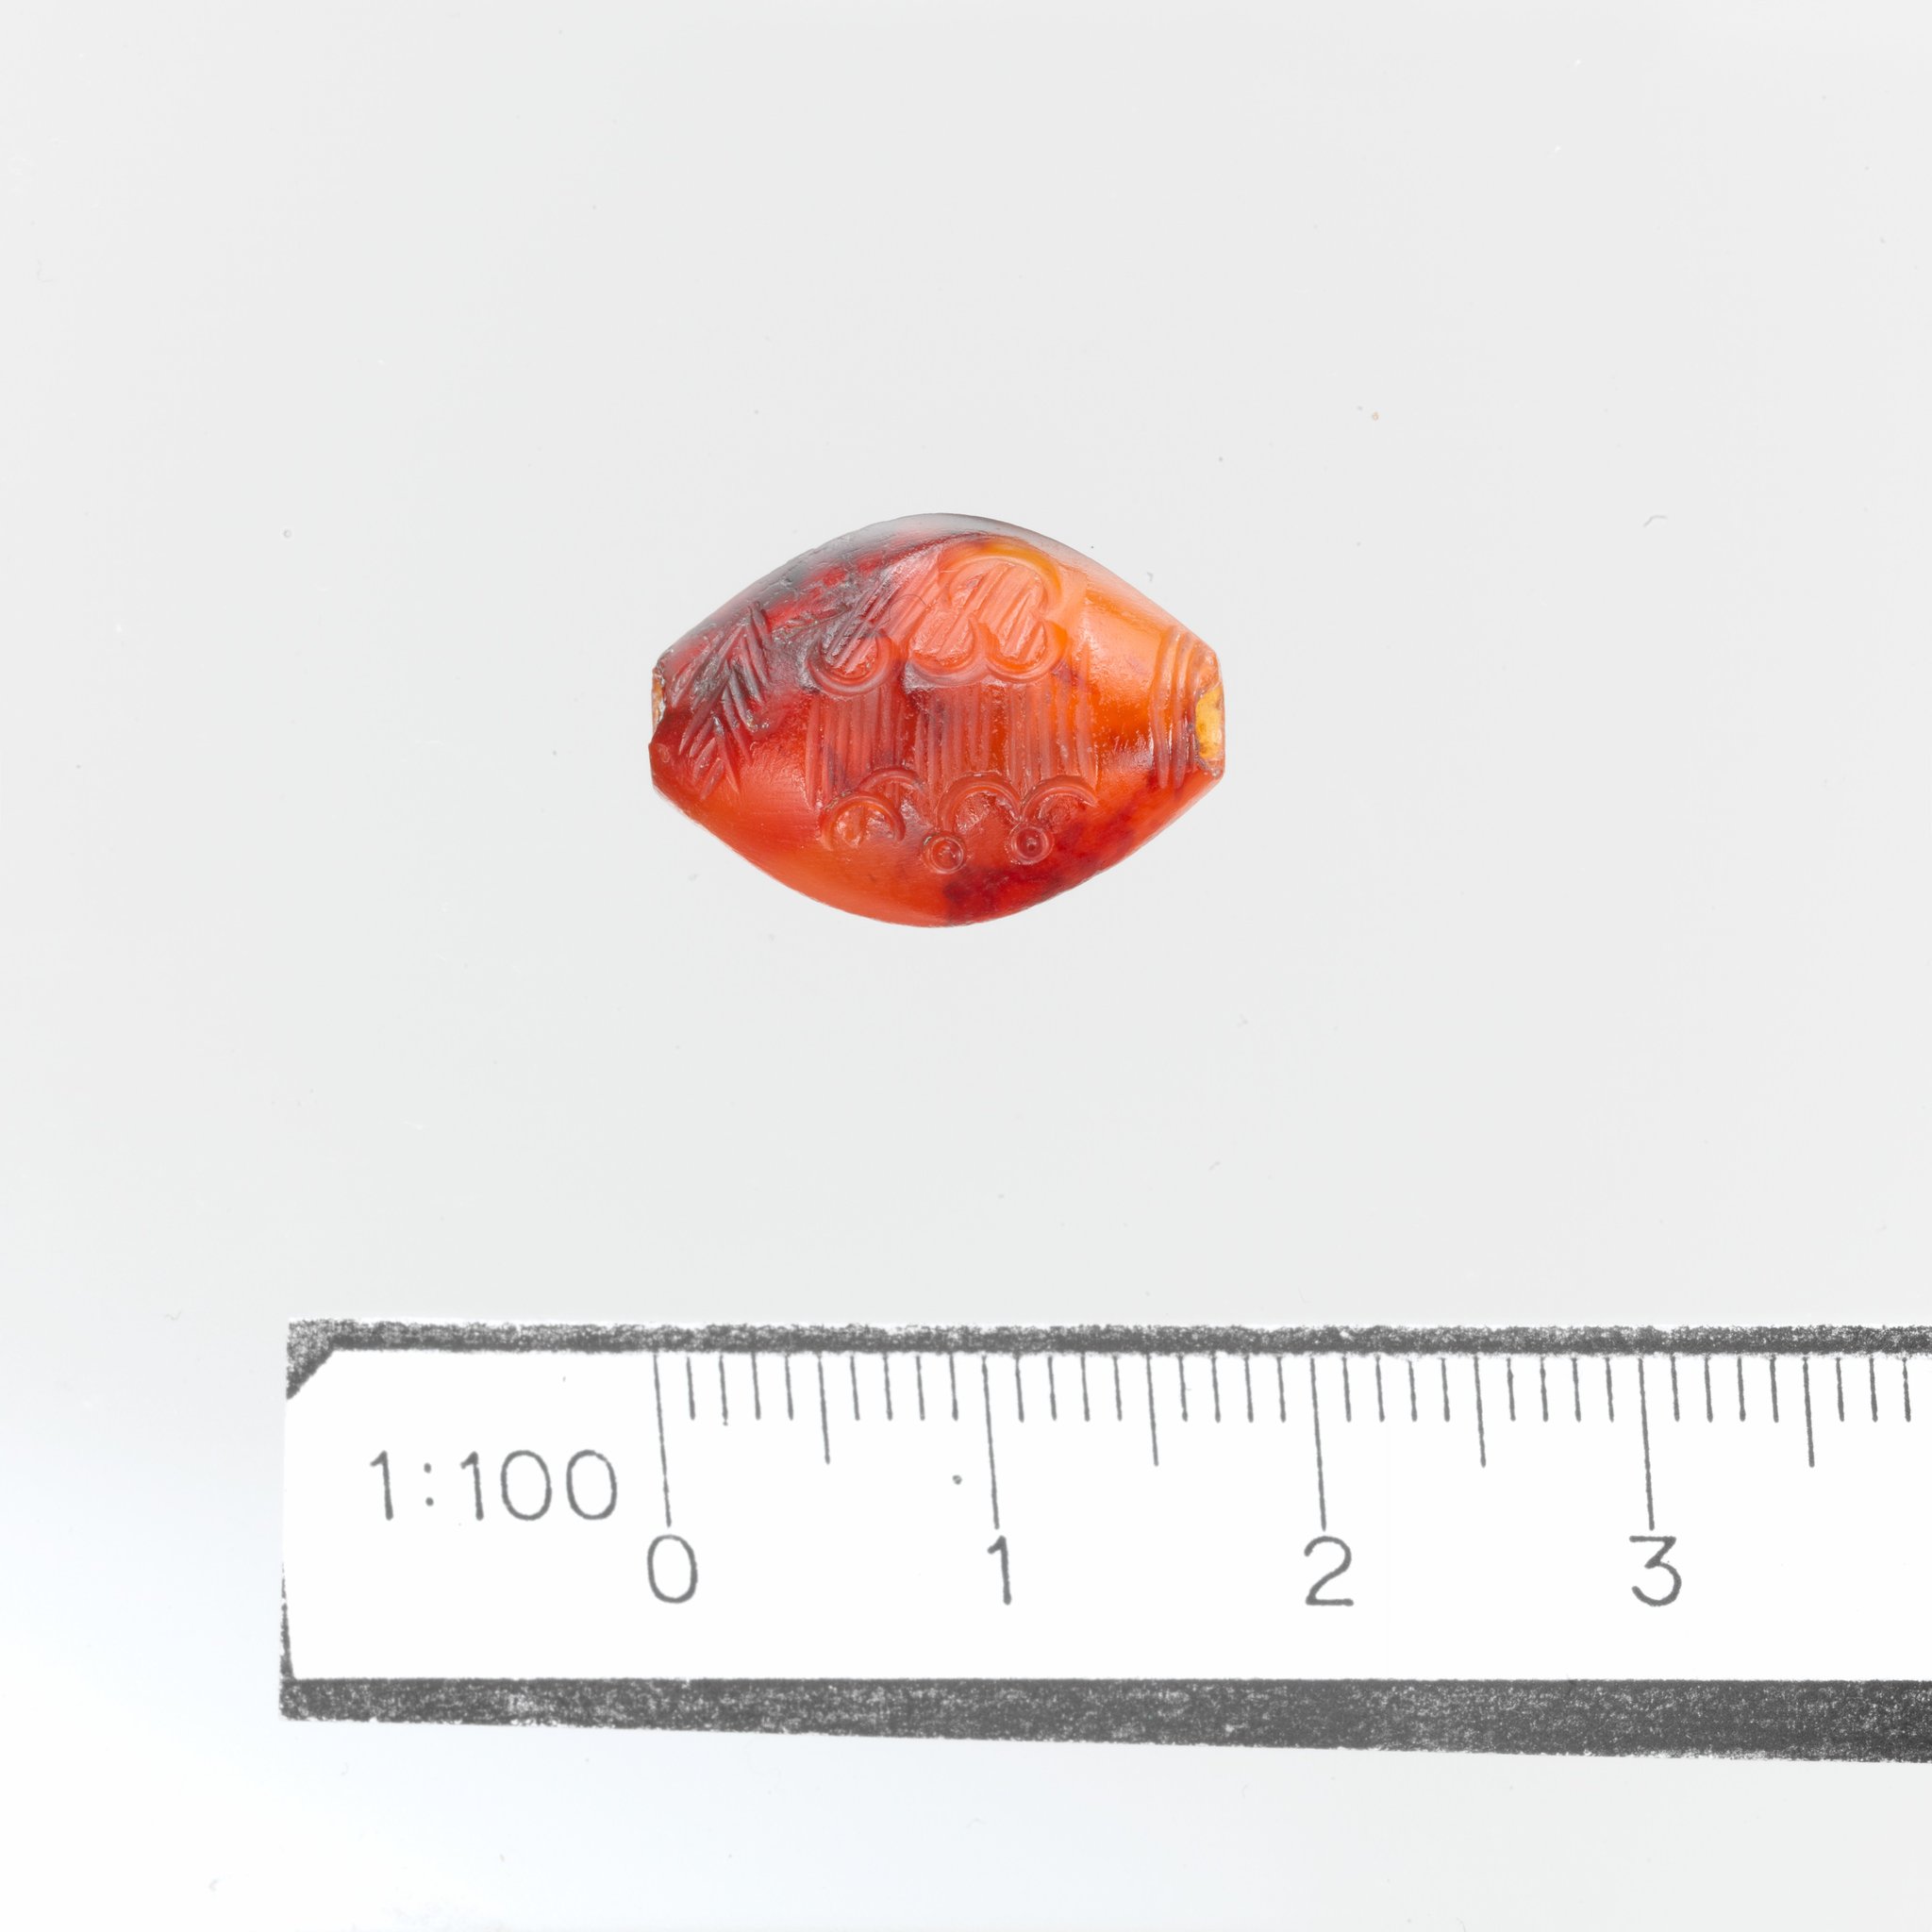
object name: seal, amygdaloid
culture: minoan, crete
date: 1650-1500 BCE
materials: gemstone